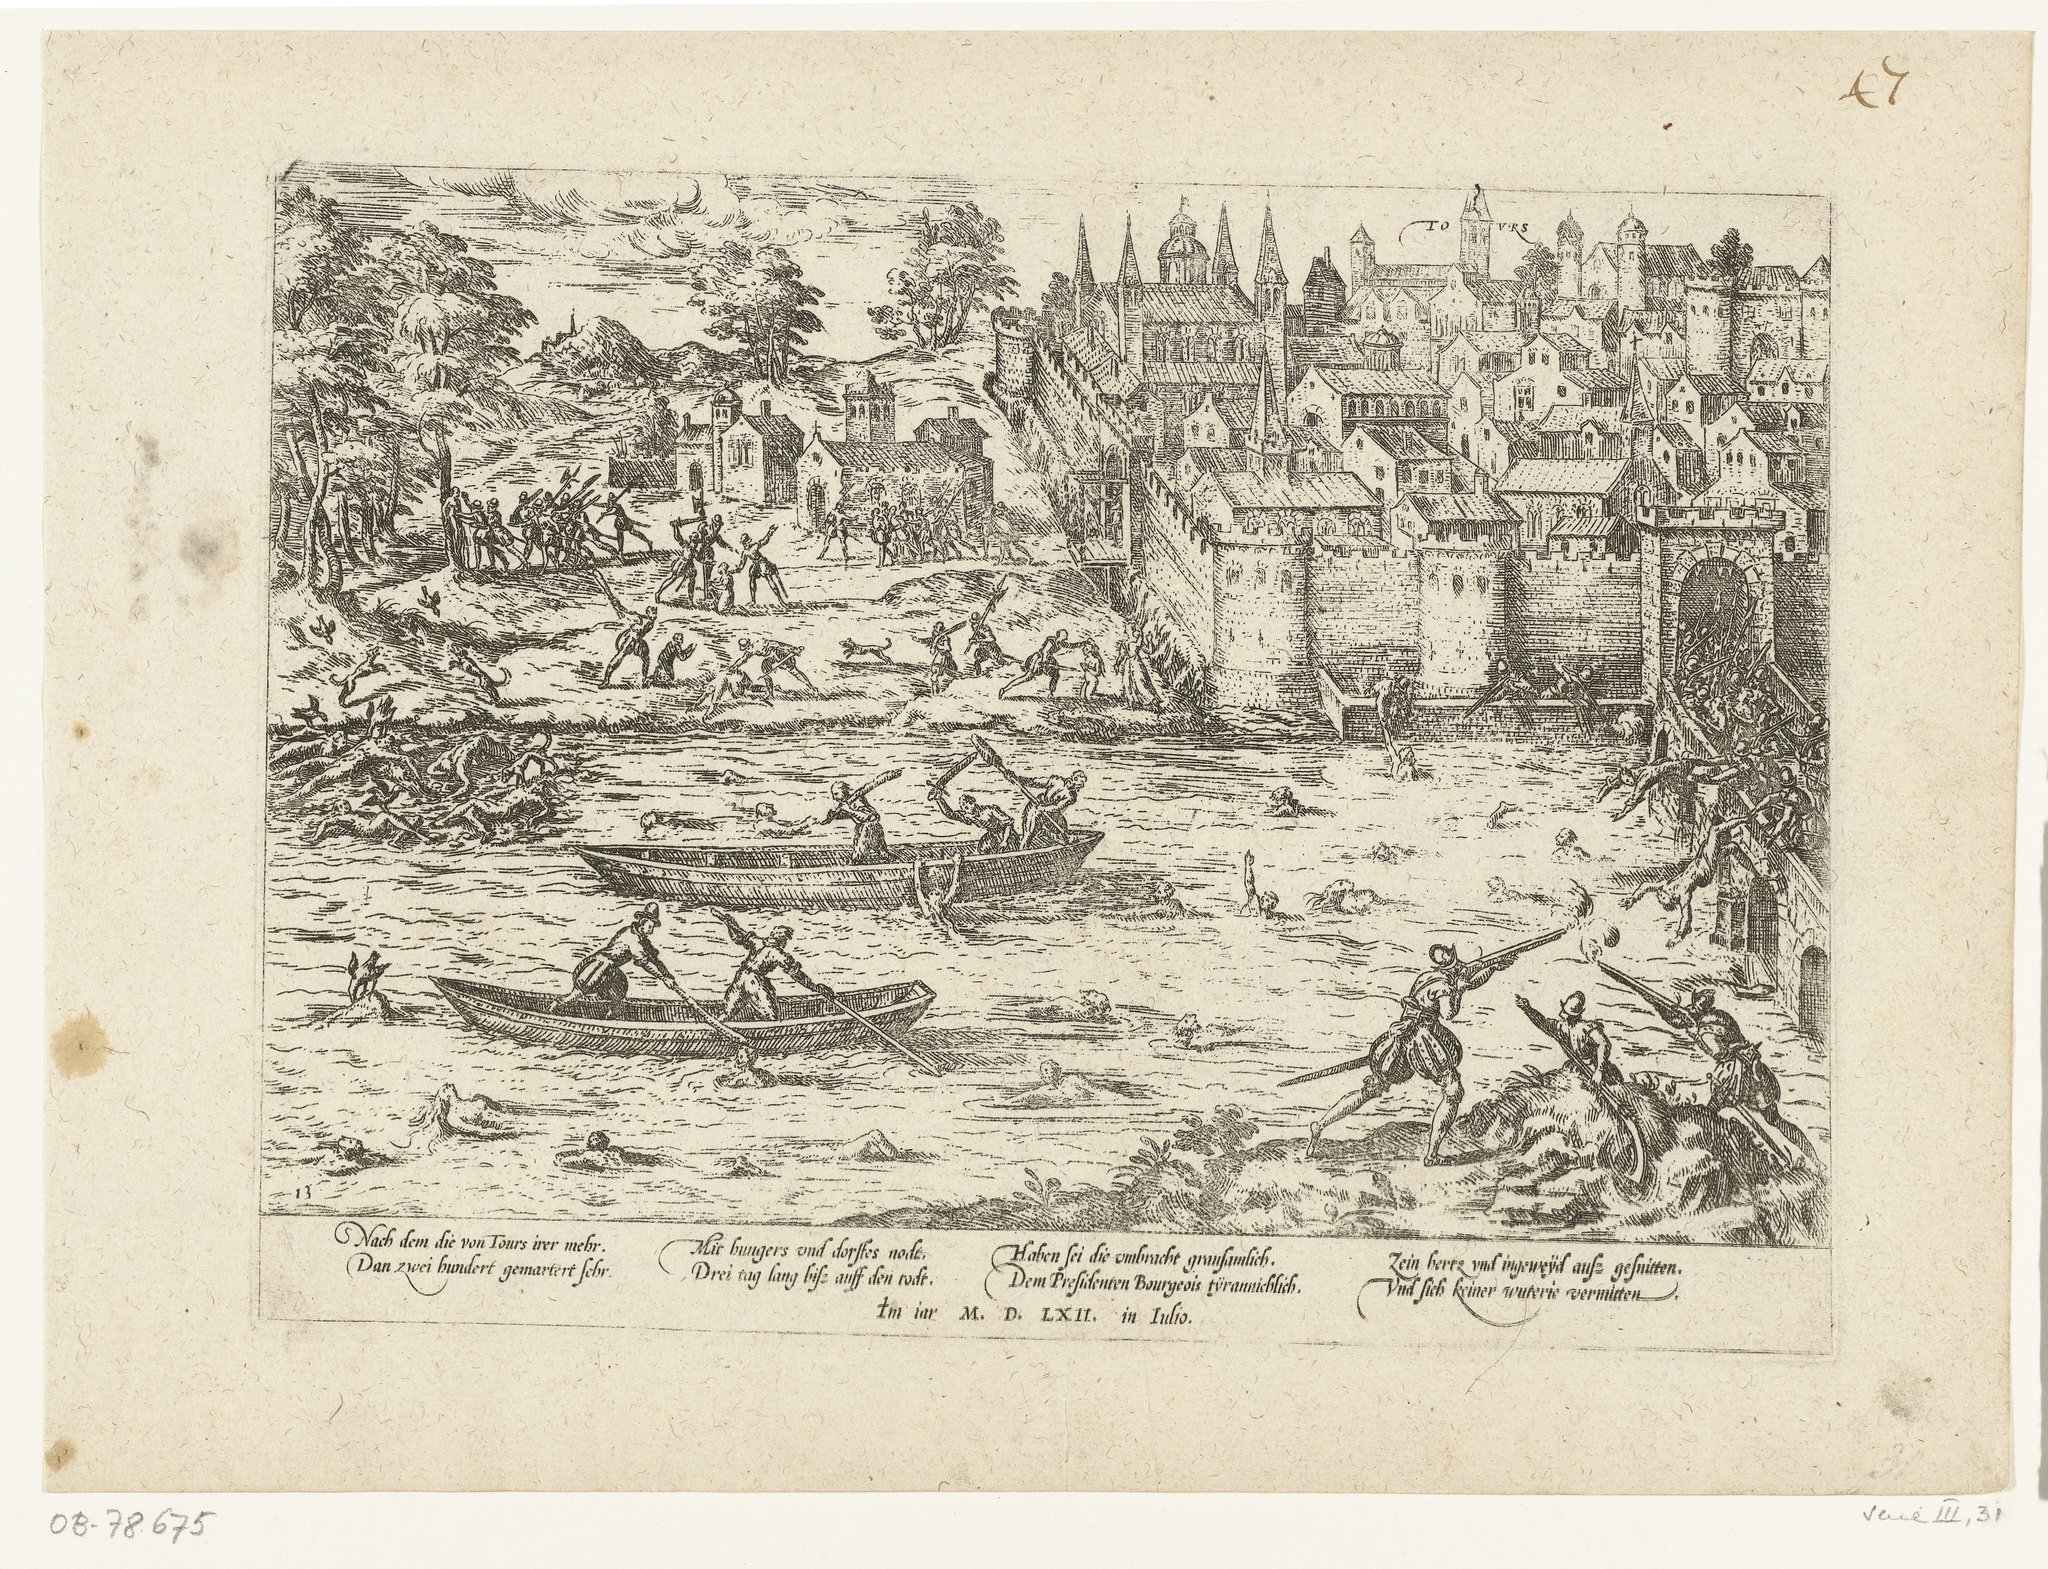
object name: print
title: Serie 3: Franse Godsdienstoorlogen, 1559-1573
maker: frans hogenberg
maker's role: print maker, publisher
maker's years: 1538-1590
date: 1565-1573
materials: paper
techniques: etching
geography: cologne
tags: massacre ~ war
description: Gekopieerd naar de prent in: Jean Tortorel et Jacques Perrissin, Premier volume contenant quarante tableaux ou Histoires diverses qui sont memorables touchant les Guerres, Massacres et Troubles advenus en France en ces dernieres annees : le tout recueilly selon le tesmoignange de ceux qui y ont esté en personne et qui les ont veus : lesquels sont pourtraits à la vérité, Genève ca. 1570. Bibliotheek Rijksmuseum: 329 A 2, pl. 14.